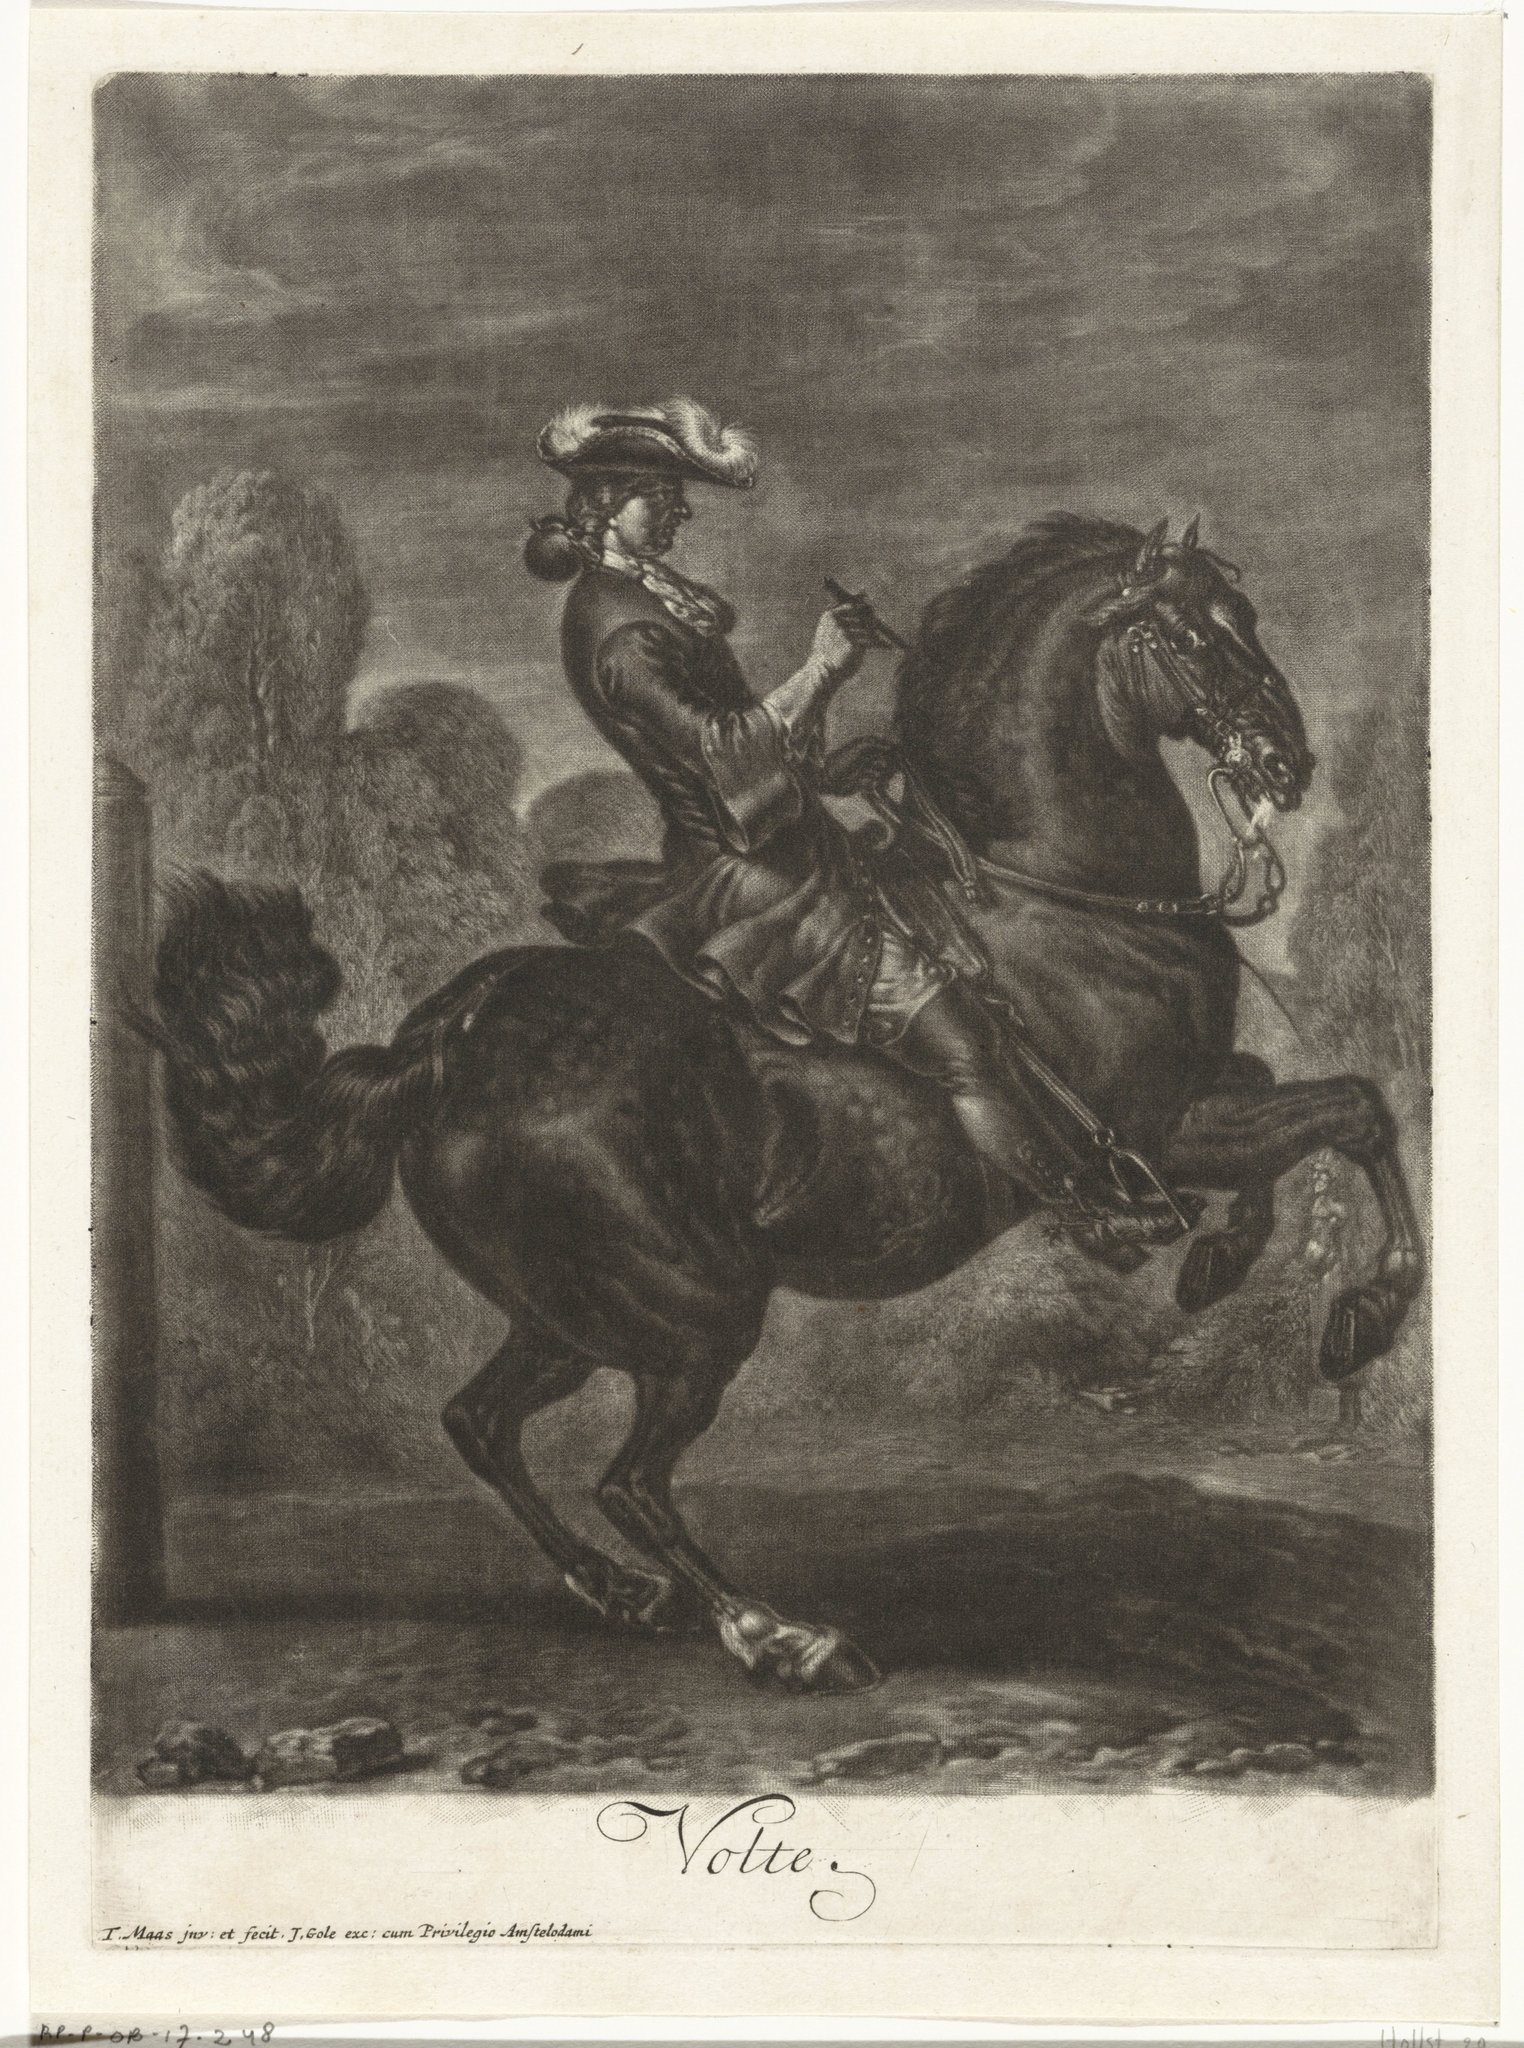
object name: print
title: Zwart steigerend paard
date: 1675-1724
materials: paper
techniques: engraving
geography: amsterdam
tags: training of horses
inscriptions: collector's mark: Lugt 240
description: Een man doet een dressuurproef met een paard. Het dier steigert naar rechts.